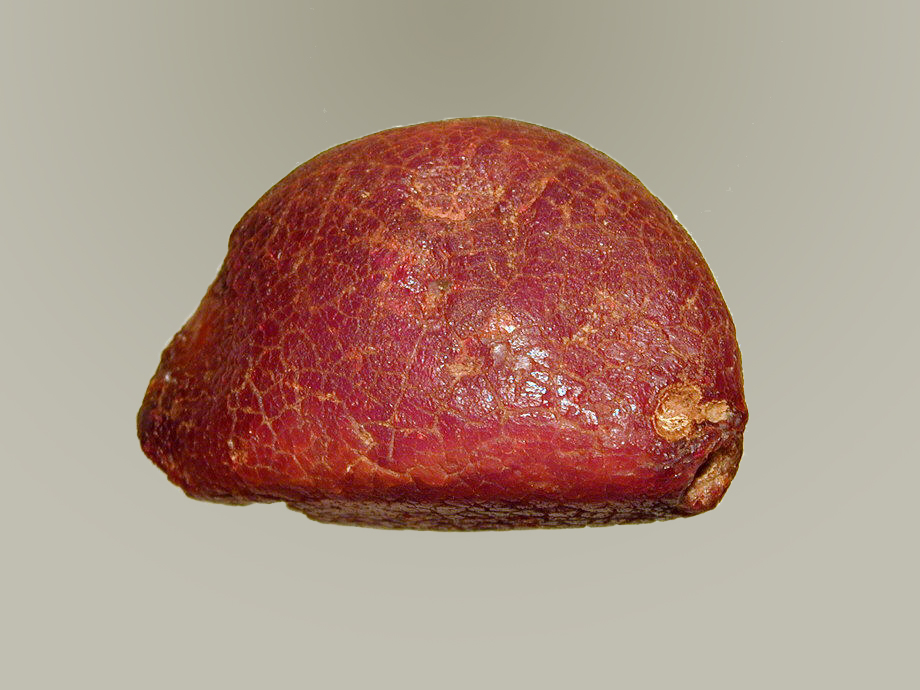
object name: fibula or amulet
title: Amber from bow of a fibula (safety pin)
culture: etruscan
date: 700-501 BCE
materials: amber